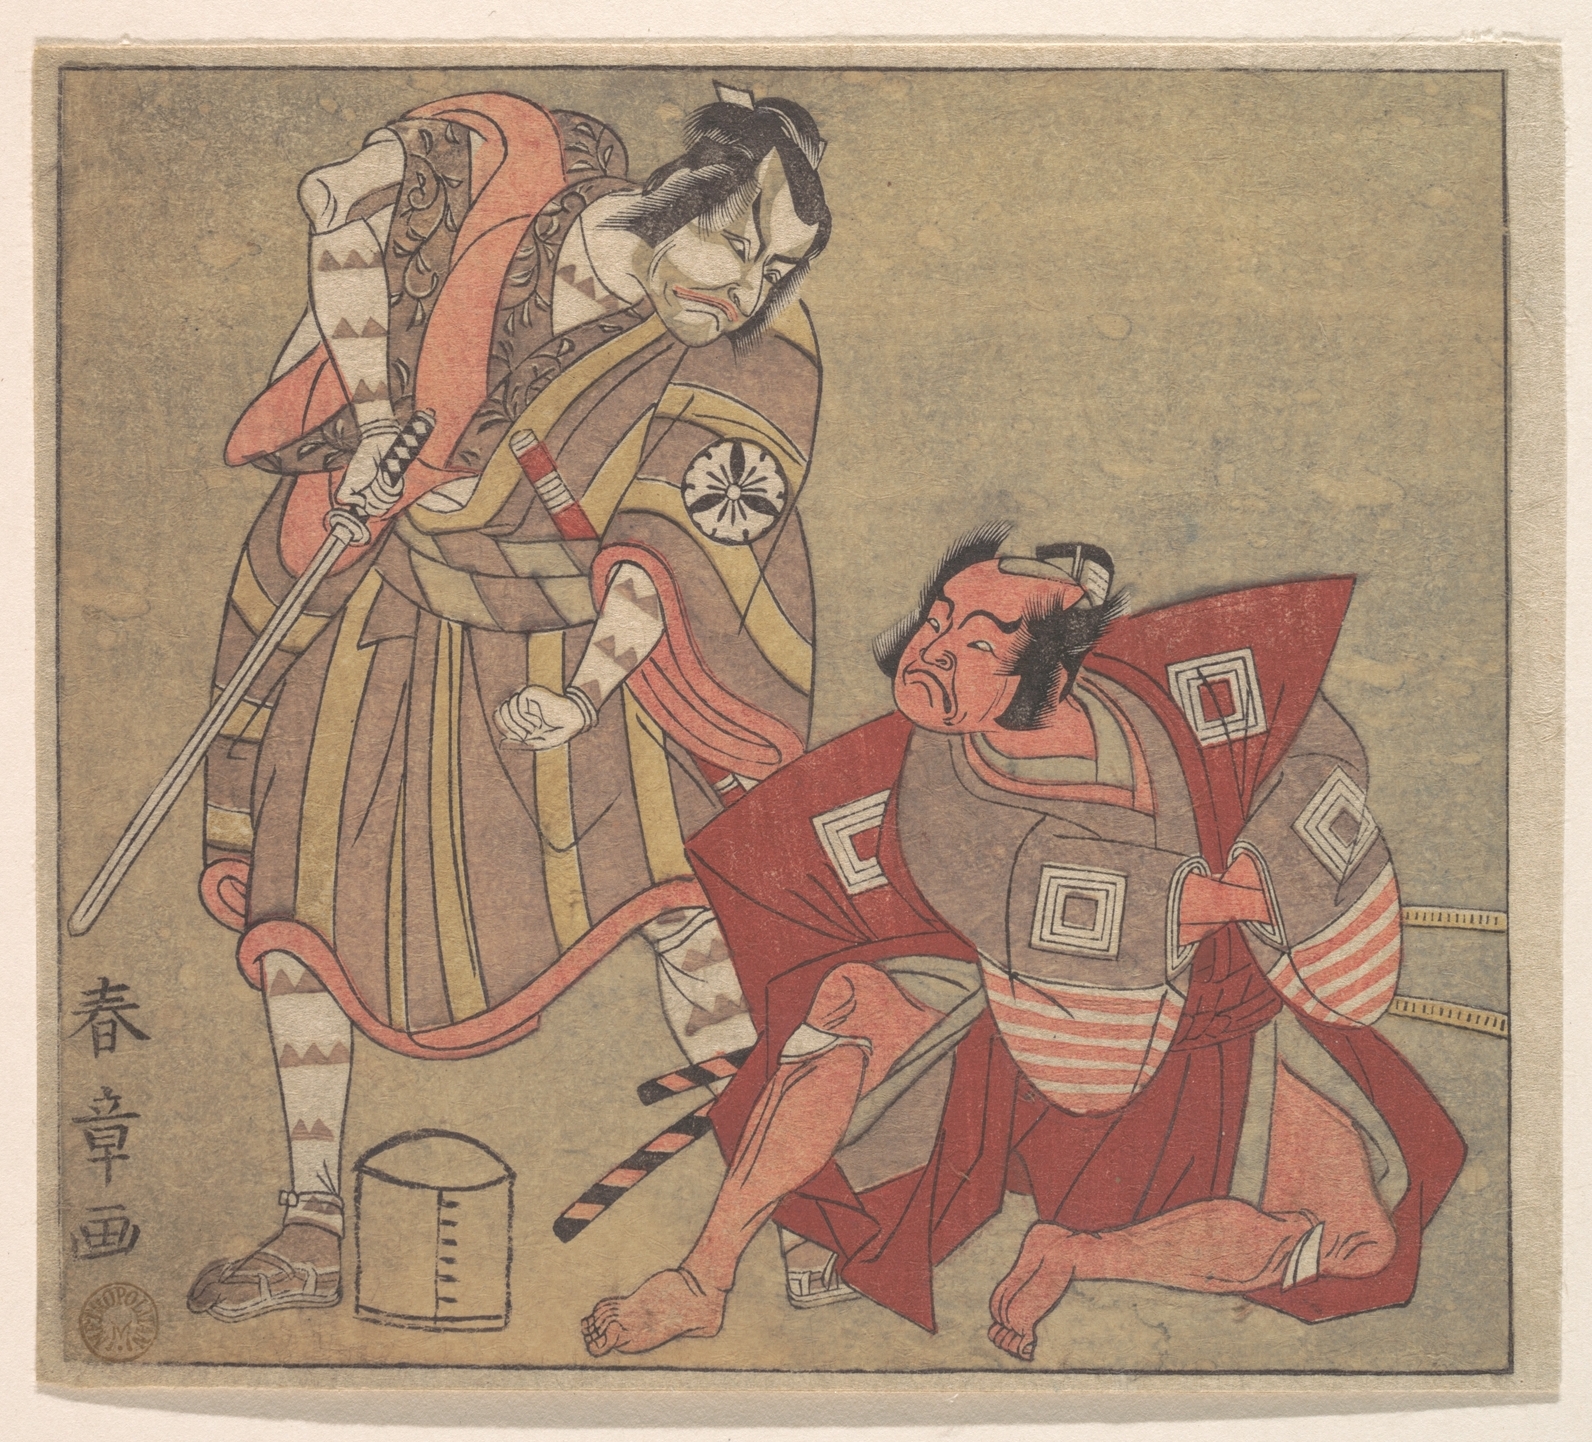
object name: woodblock print nishiki e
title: Scene from a Drama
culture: japanese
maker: katsukawa shunshō 勝川春章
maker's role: artist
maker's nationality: japanese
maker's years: 1726-1792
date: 1770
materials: ink, paper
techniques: nishiki e, woodblock print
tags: swords,men,actors